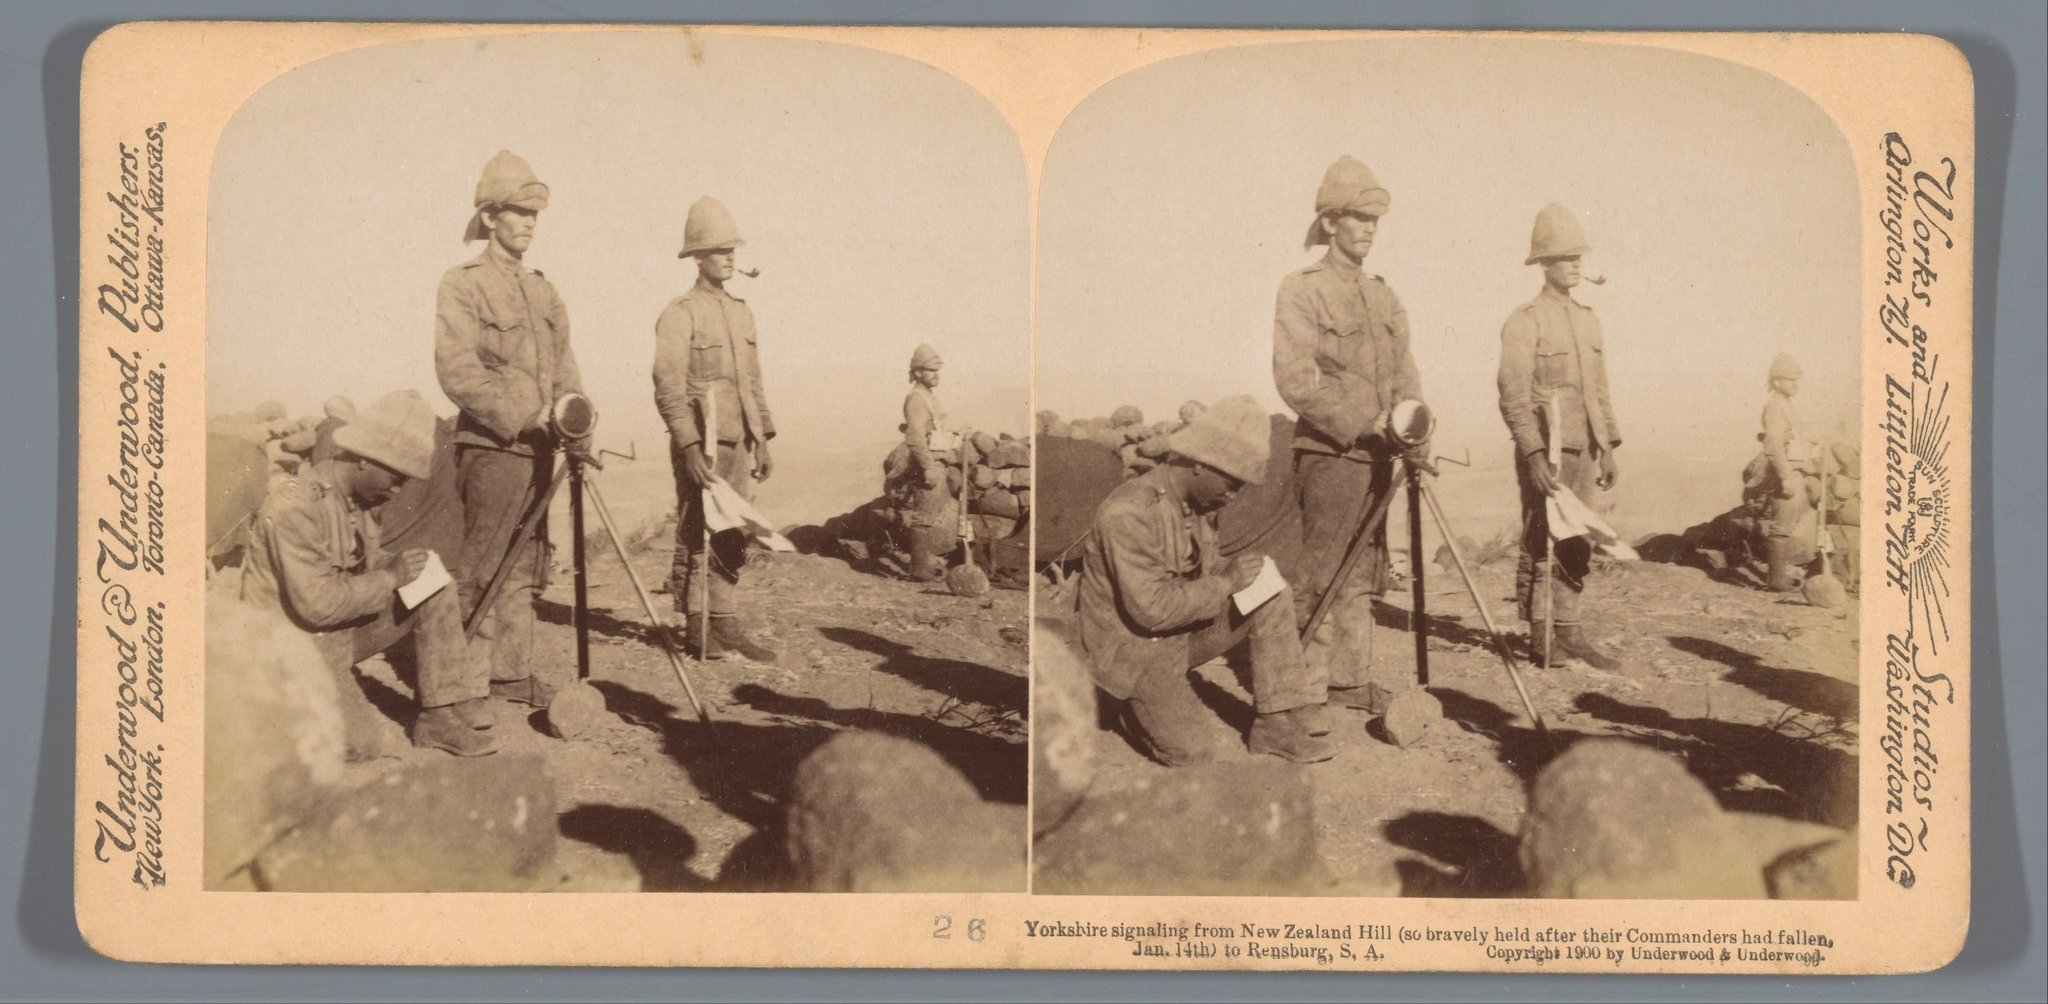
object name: stereograph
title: Britse soldaten seinen naar Rensburg vanaf New Zealand Hill, 14 januari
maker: Anonymous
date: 1900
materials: cardboard, paper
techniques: albumen print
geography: new york city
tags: the soldier; the soldier's life, (military) signals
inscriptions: inscription, copyright notice: ‘Copyright 1901 by Underwood & Underwood.’, number: ‘26’, inscription: ‘Works and Studios ~/ Arlington, N.J. Littleton, N.H. Washington, D.C.’